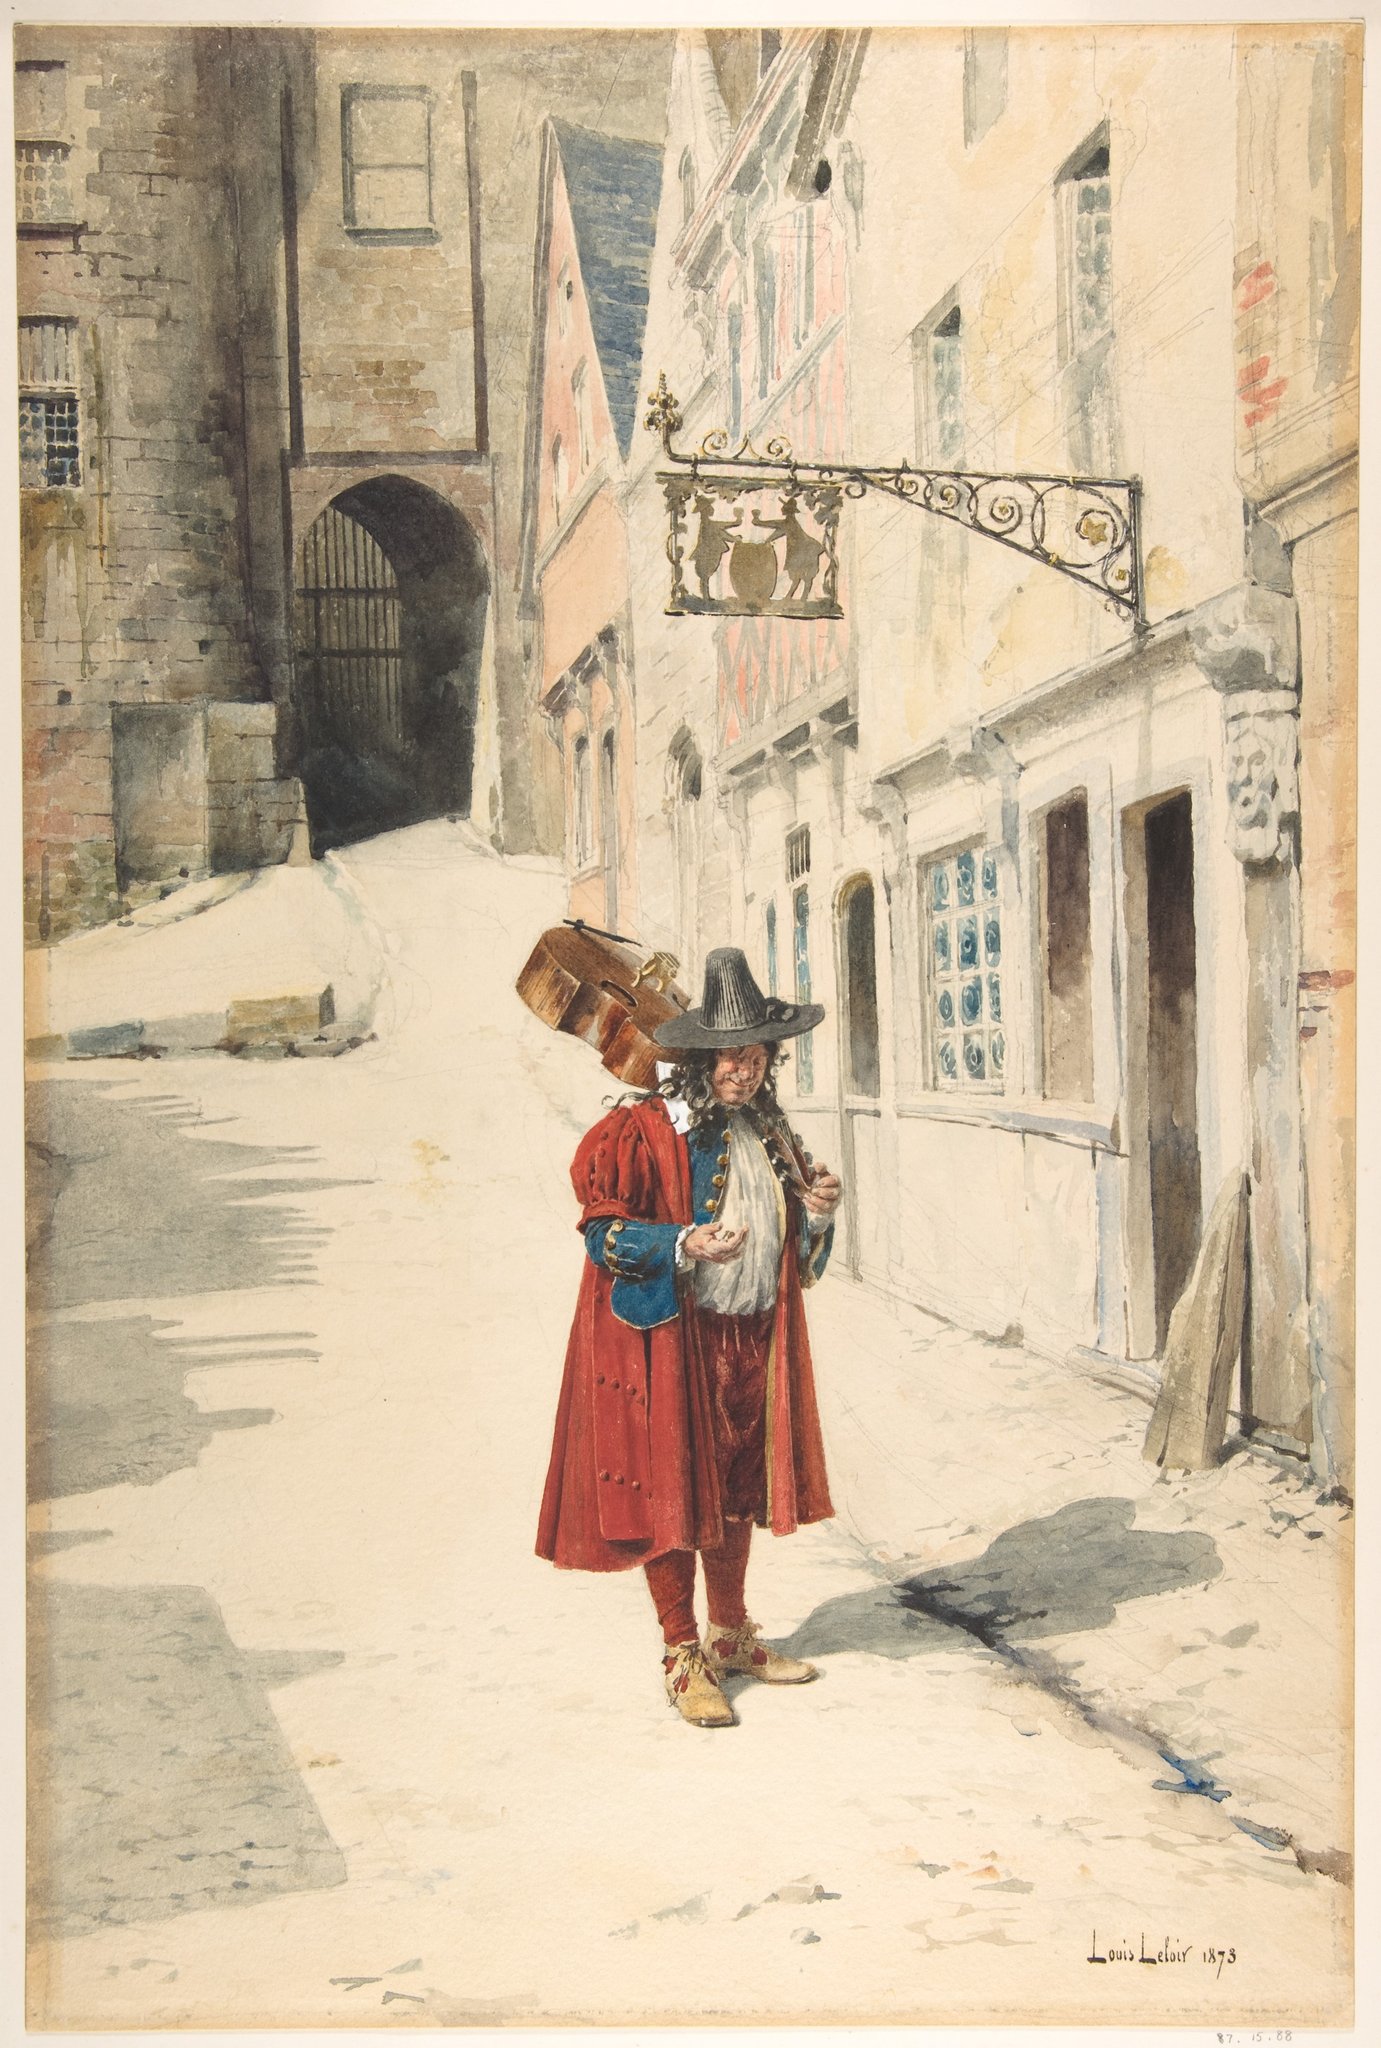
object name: drawing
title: Wandering Minstrel; Old Nuremberg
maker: alexandre-louis leloir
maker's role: artist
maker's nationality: french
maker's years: 1843-1884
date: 1843-1884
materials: watercolor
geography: france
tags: musical instruments,buildings,hats,men